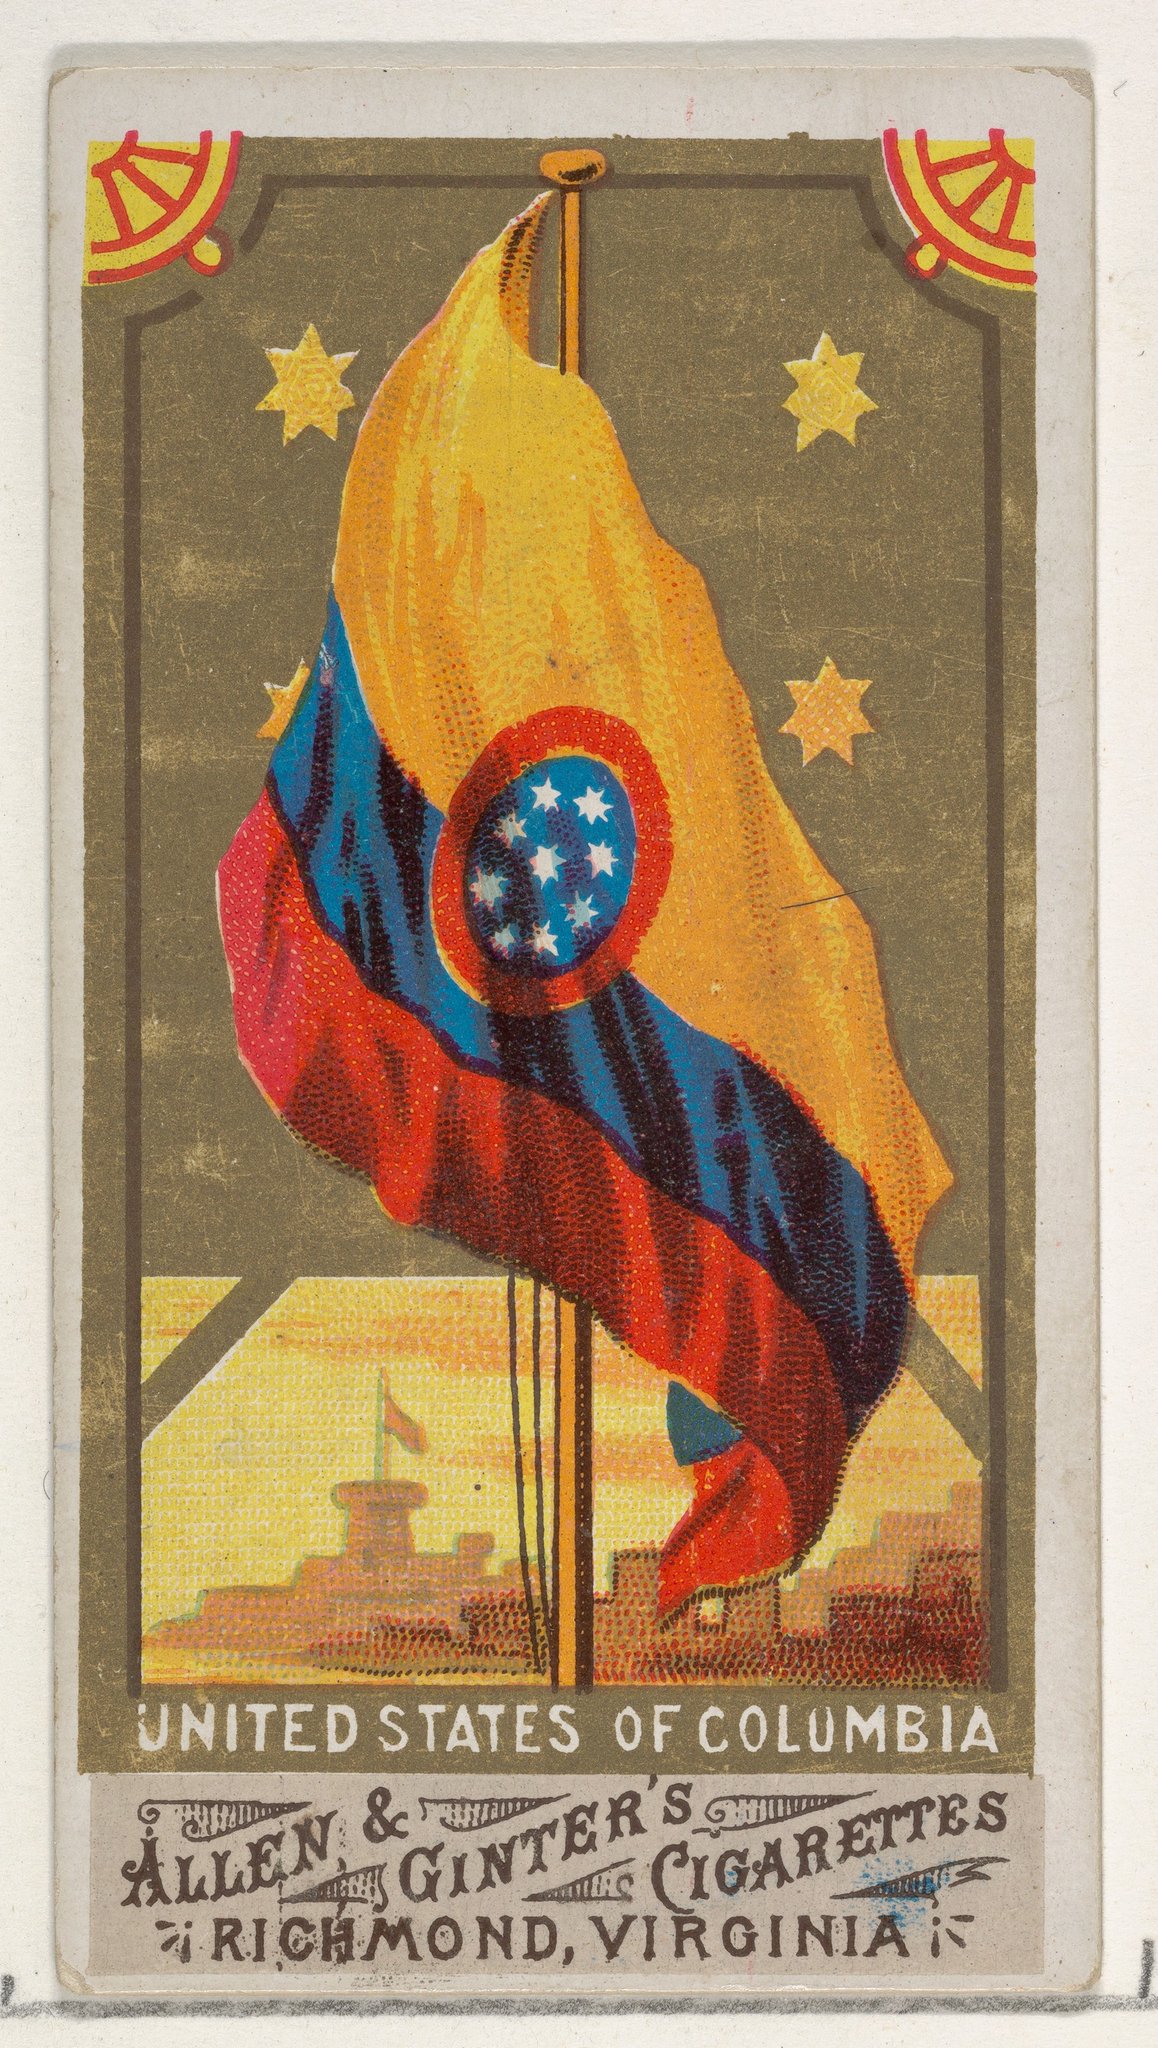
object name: print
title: United States of Columbia, from Flags of All Nations, Series 1 (N9) for Allen & Ginter Cigarettes Brands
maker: allen & ginter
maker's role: publisher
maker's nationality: american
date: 1887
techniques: color lithograph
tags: flags